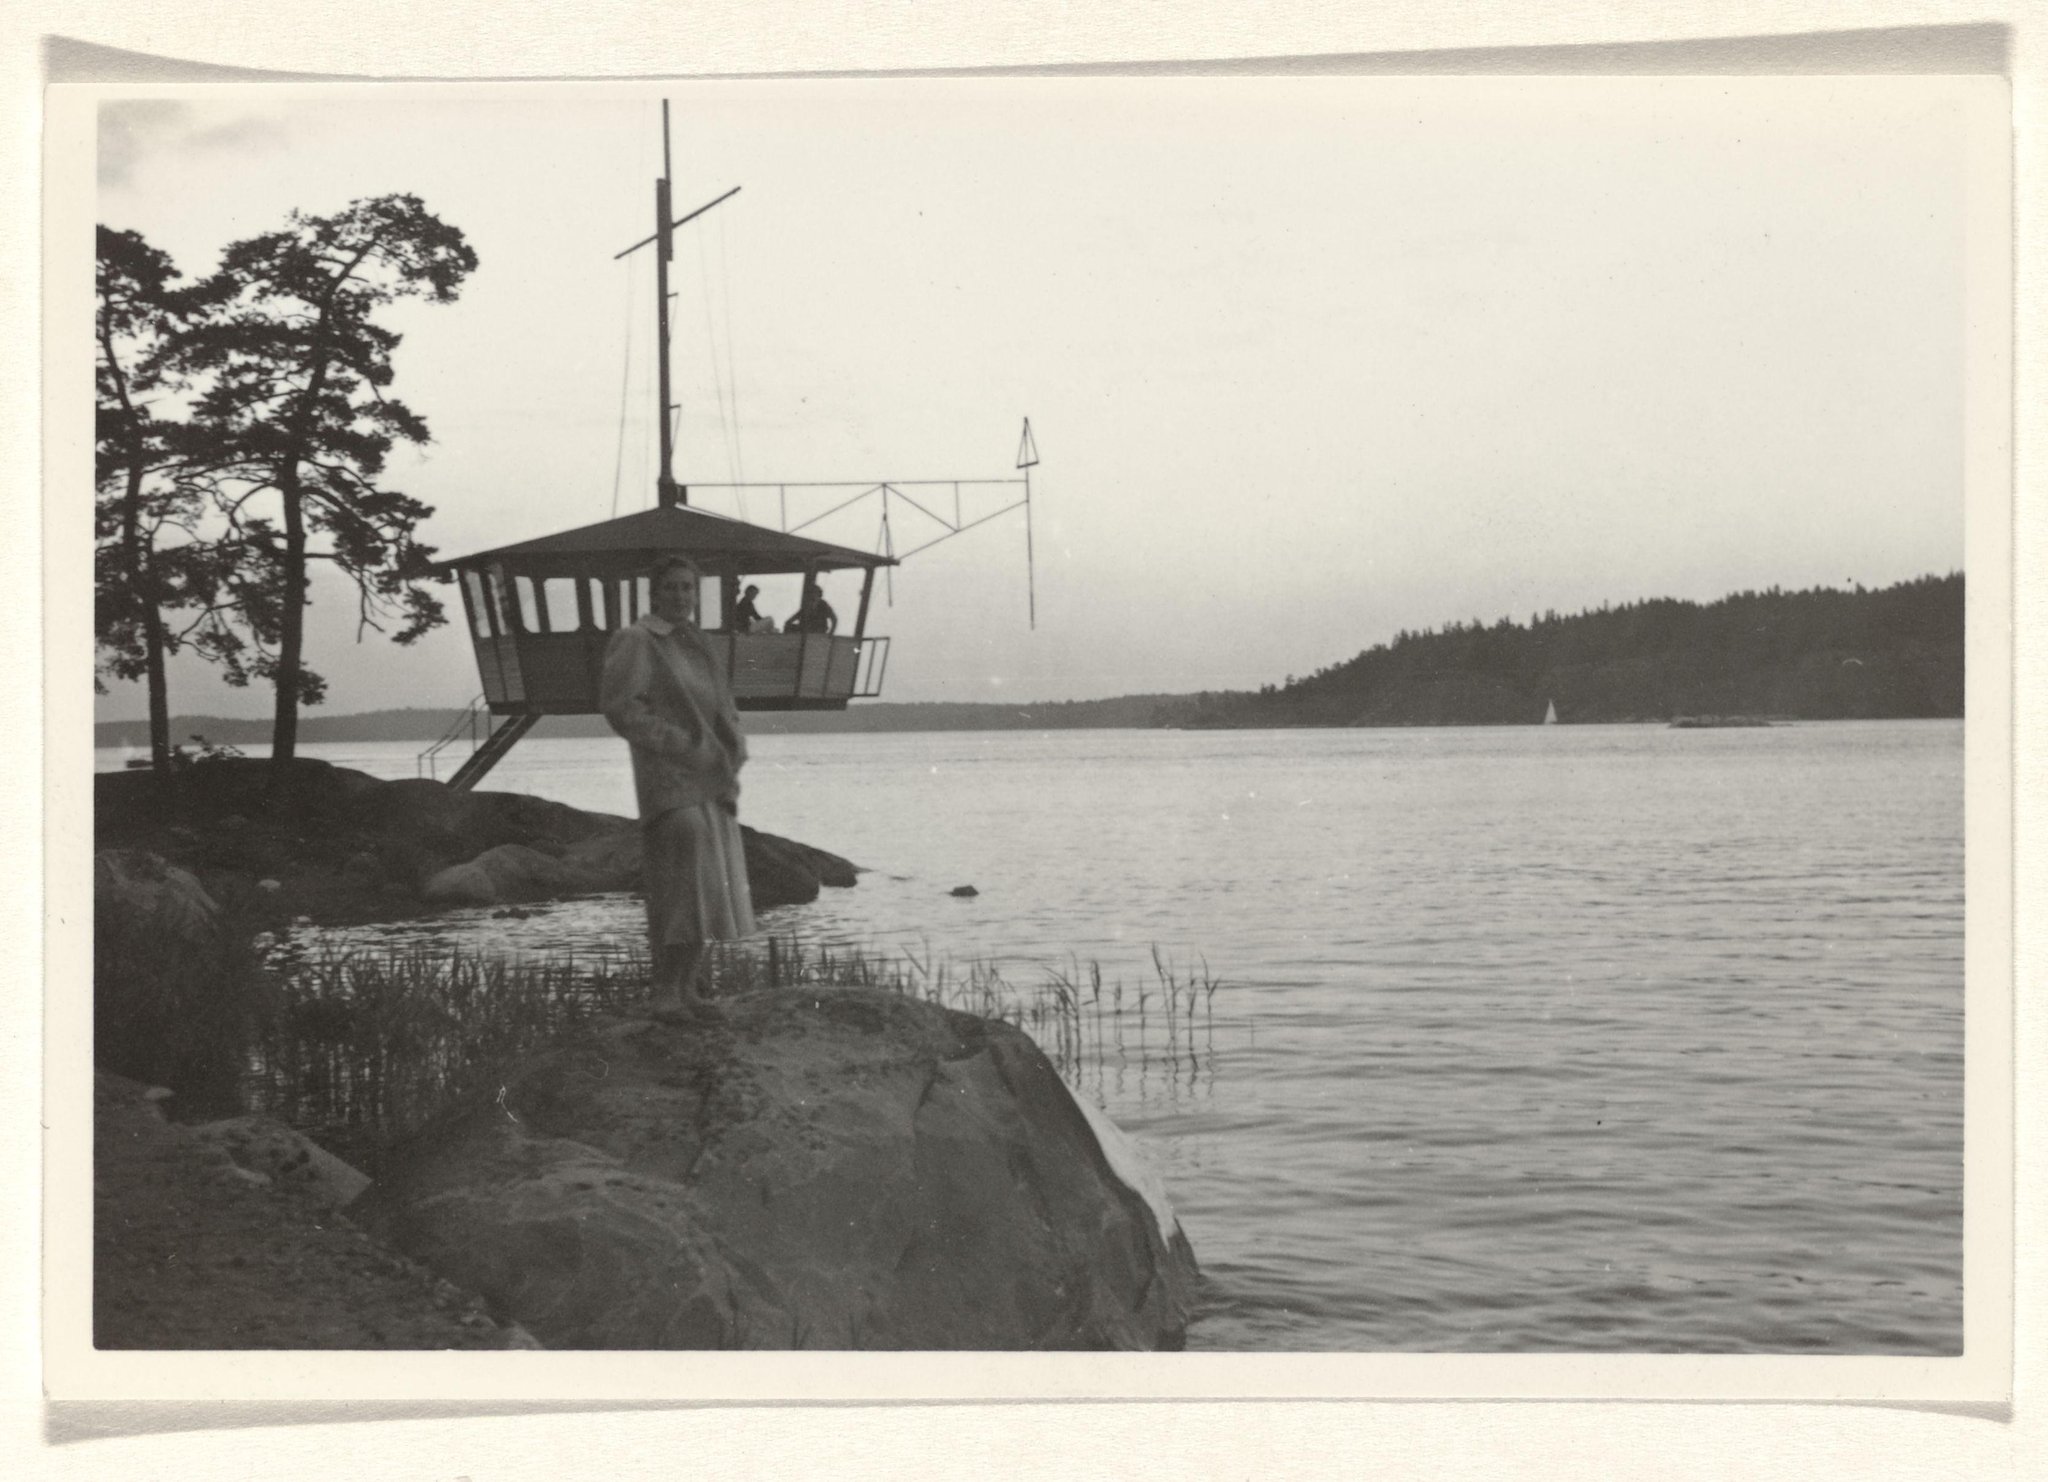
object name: photograph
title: Isabel Wachenheimer staand voor een uitkijktoren bij een meer dat is omringd door bergen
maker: Anonymous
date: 1945-1958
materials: photographic support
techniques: gelatin silver print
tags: isabel wachenheimer-elon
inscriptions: number: ‘2/11’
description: Isabel Wachenheimer staand in lange jas, voor een uitkijktoren bij een meer dat is omringd door bergen.